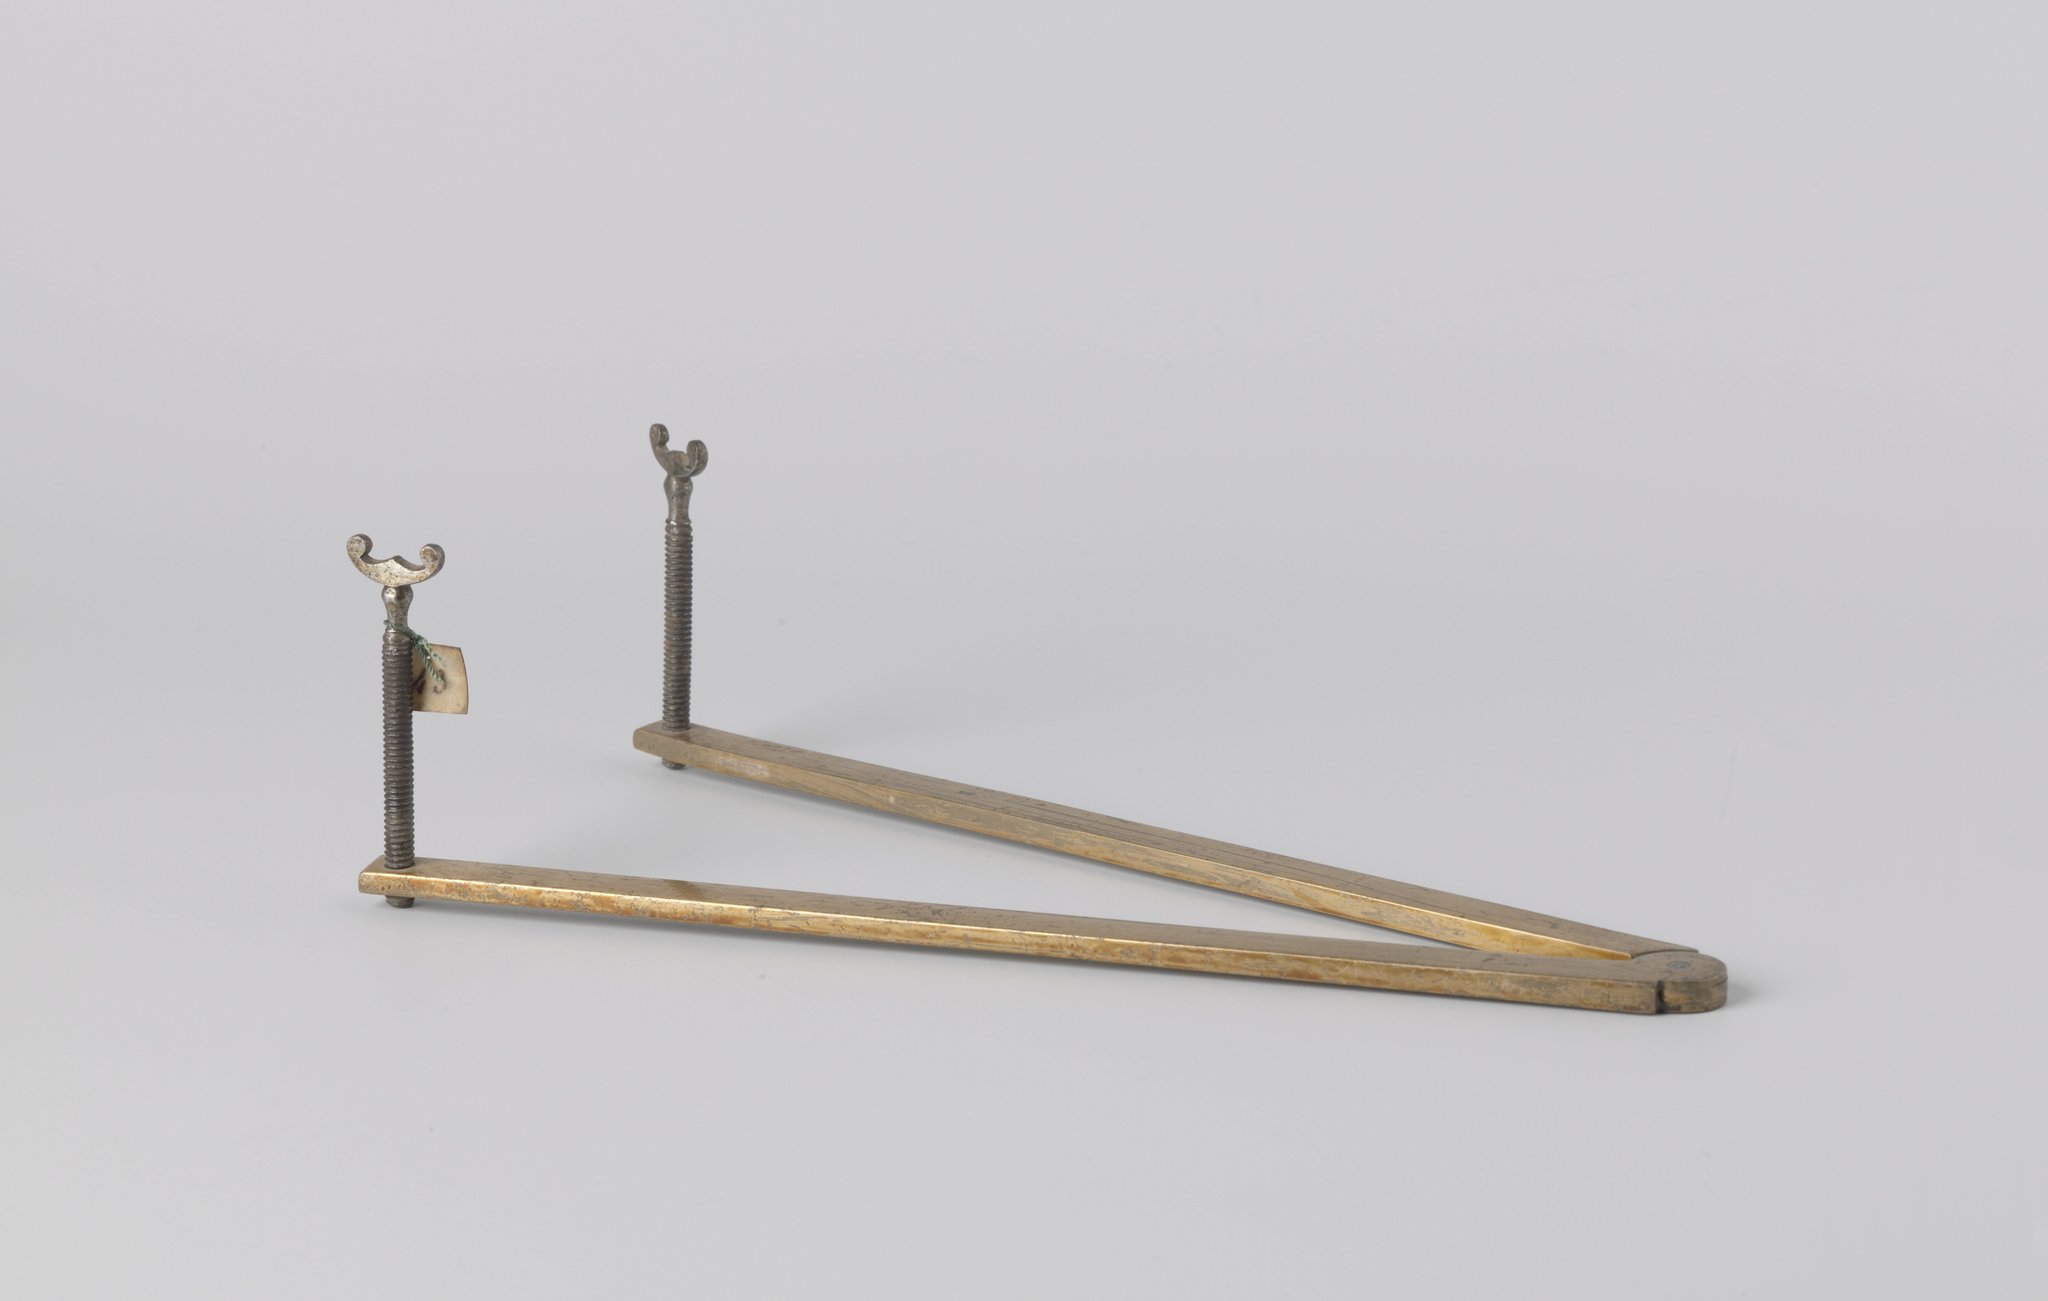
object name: compass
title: Passer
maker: Anonymous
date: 1850-1900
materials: brass, metal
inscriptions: label: ‘43’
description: Instrument met twee benen, aan de uiteinden zijn twee schroeven bevestigd.